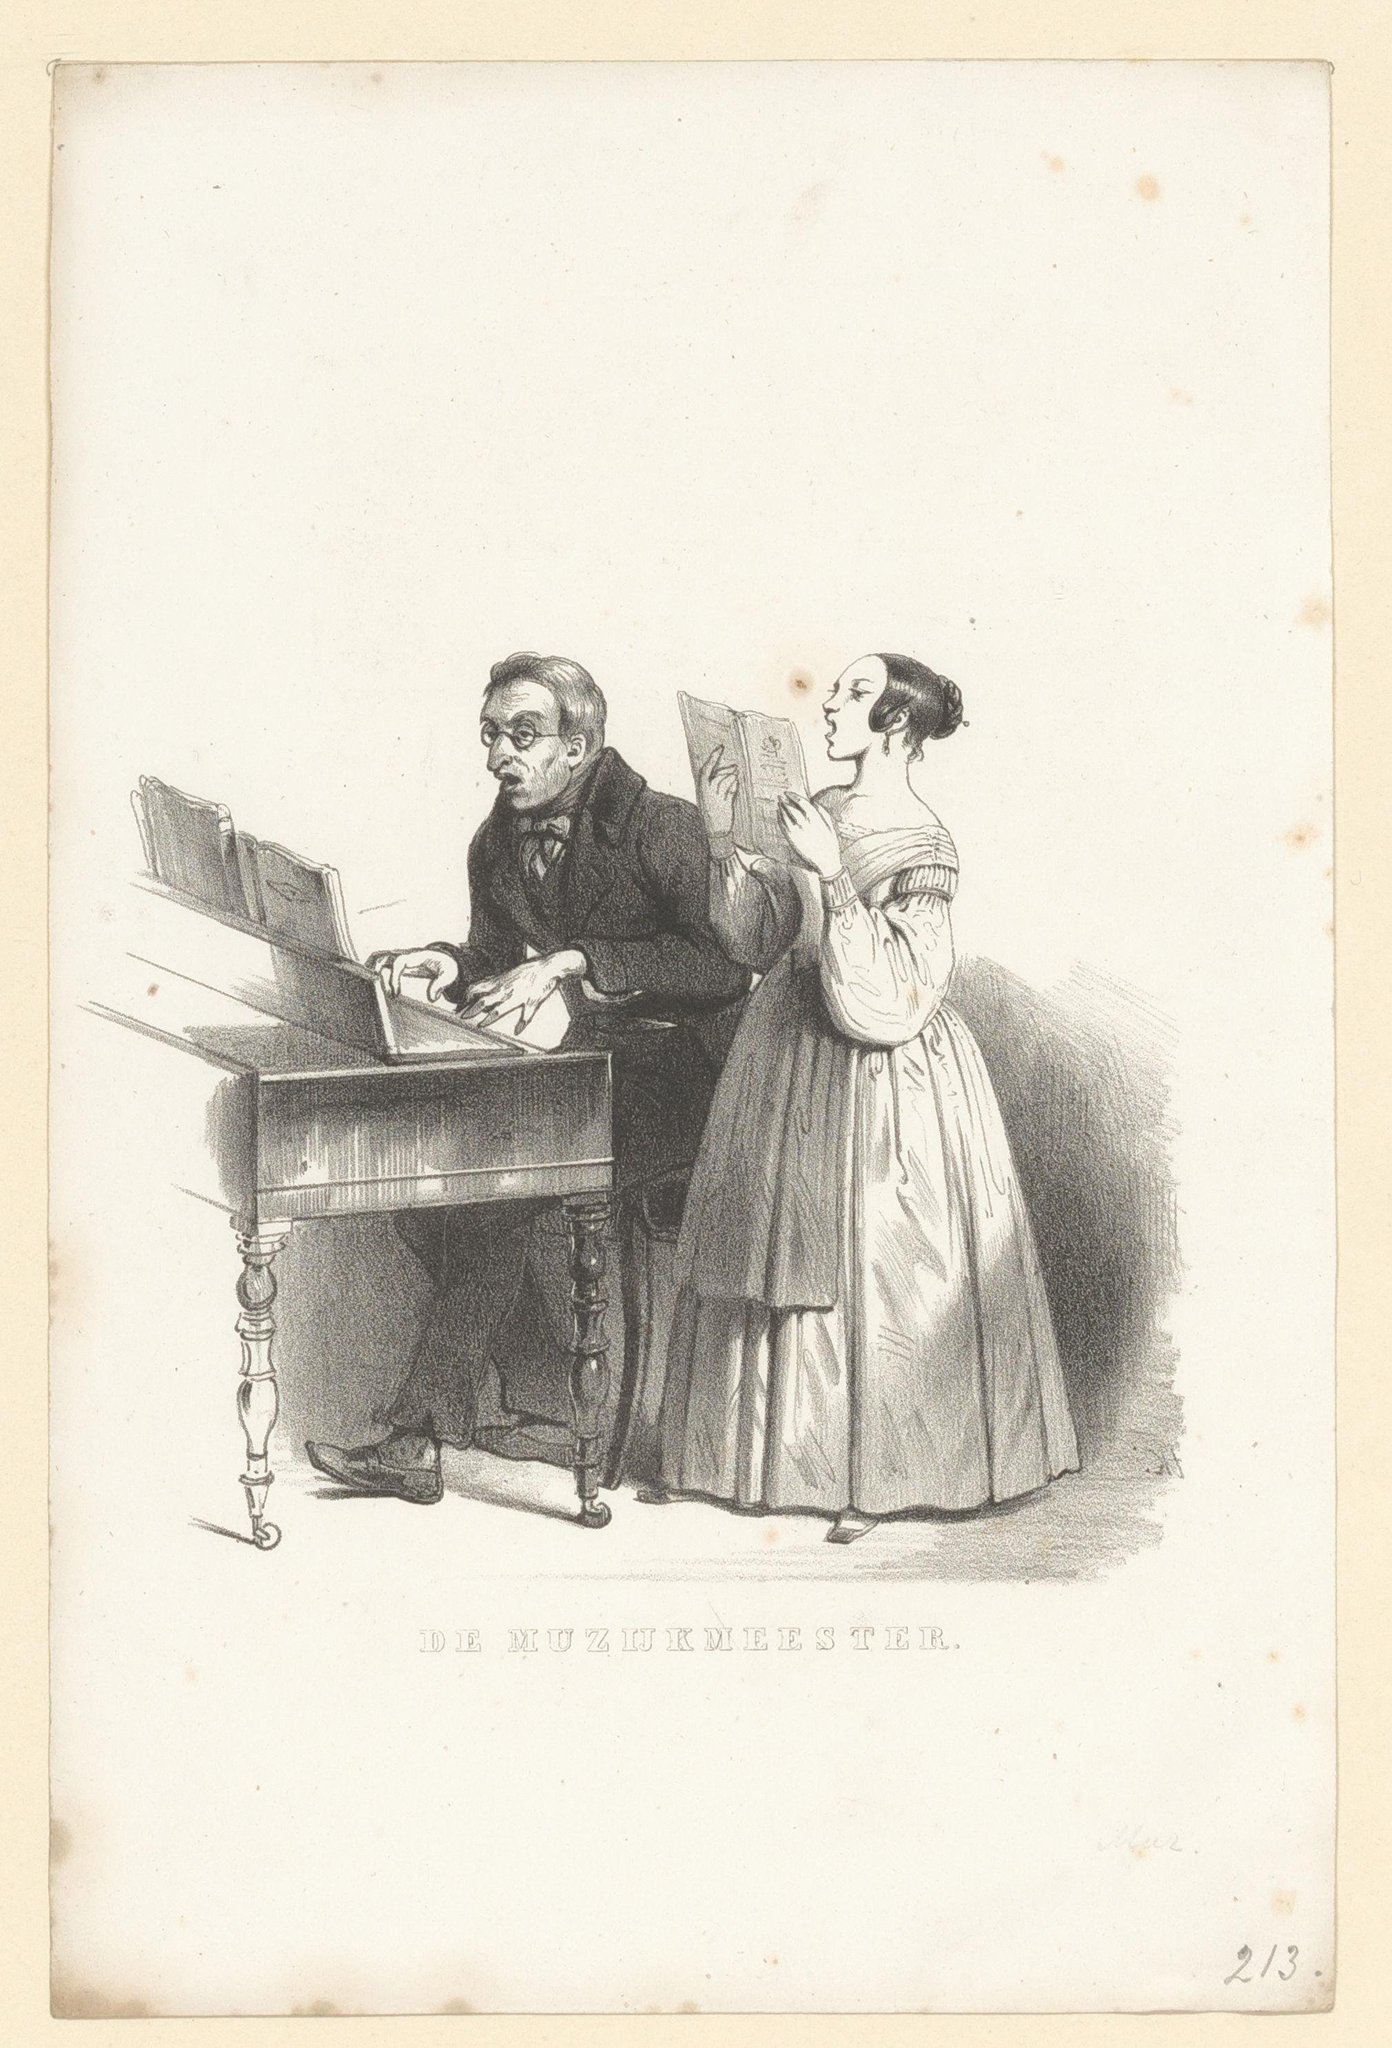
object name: print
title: De Muzijkmeester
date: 1841-1842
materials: paper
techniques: lithograph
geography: amsterdam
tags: one person playing keyboard instrument, musician(s) accompanying singer(s), vocal music, singing, pianoforte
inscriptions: collector's mark: Lugt 1641, stamp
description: Man begeleidt op de piano een zingende jonge vrouw. Onderwerpsrubrieken binnen de Atlas Zeden en Gewoonten: Muziek en muziekinstrumenten: Clavecimbaal en zang.